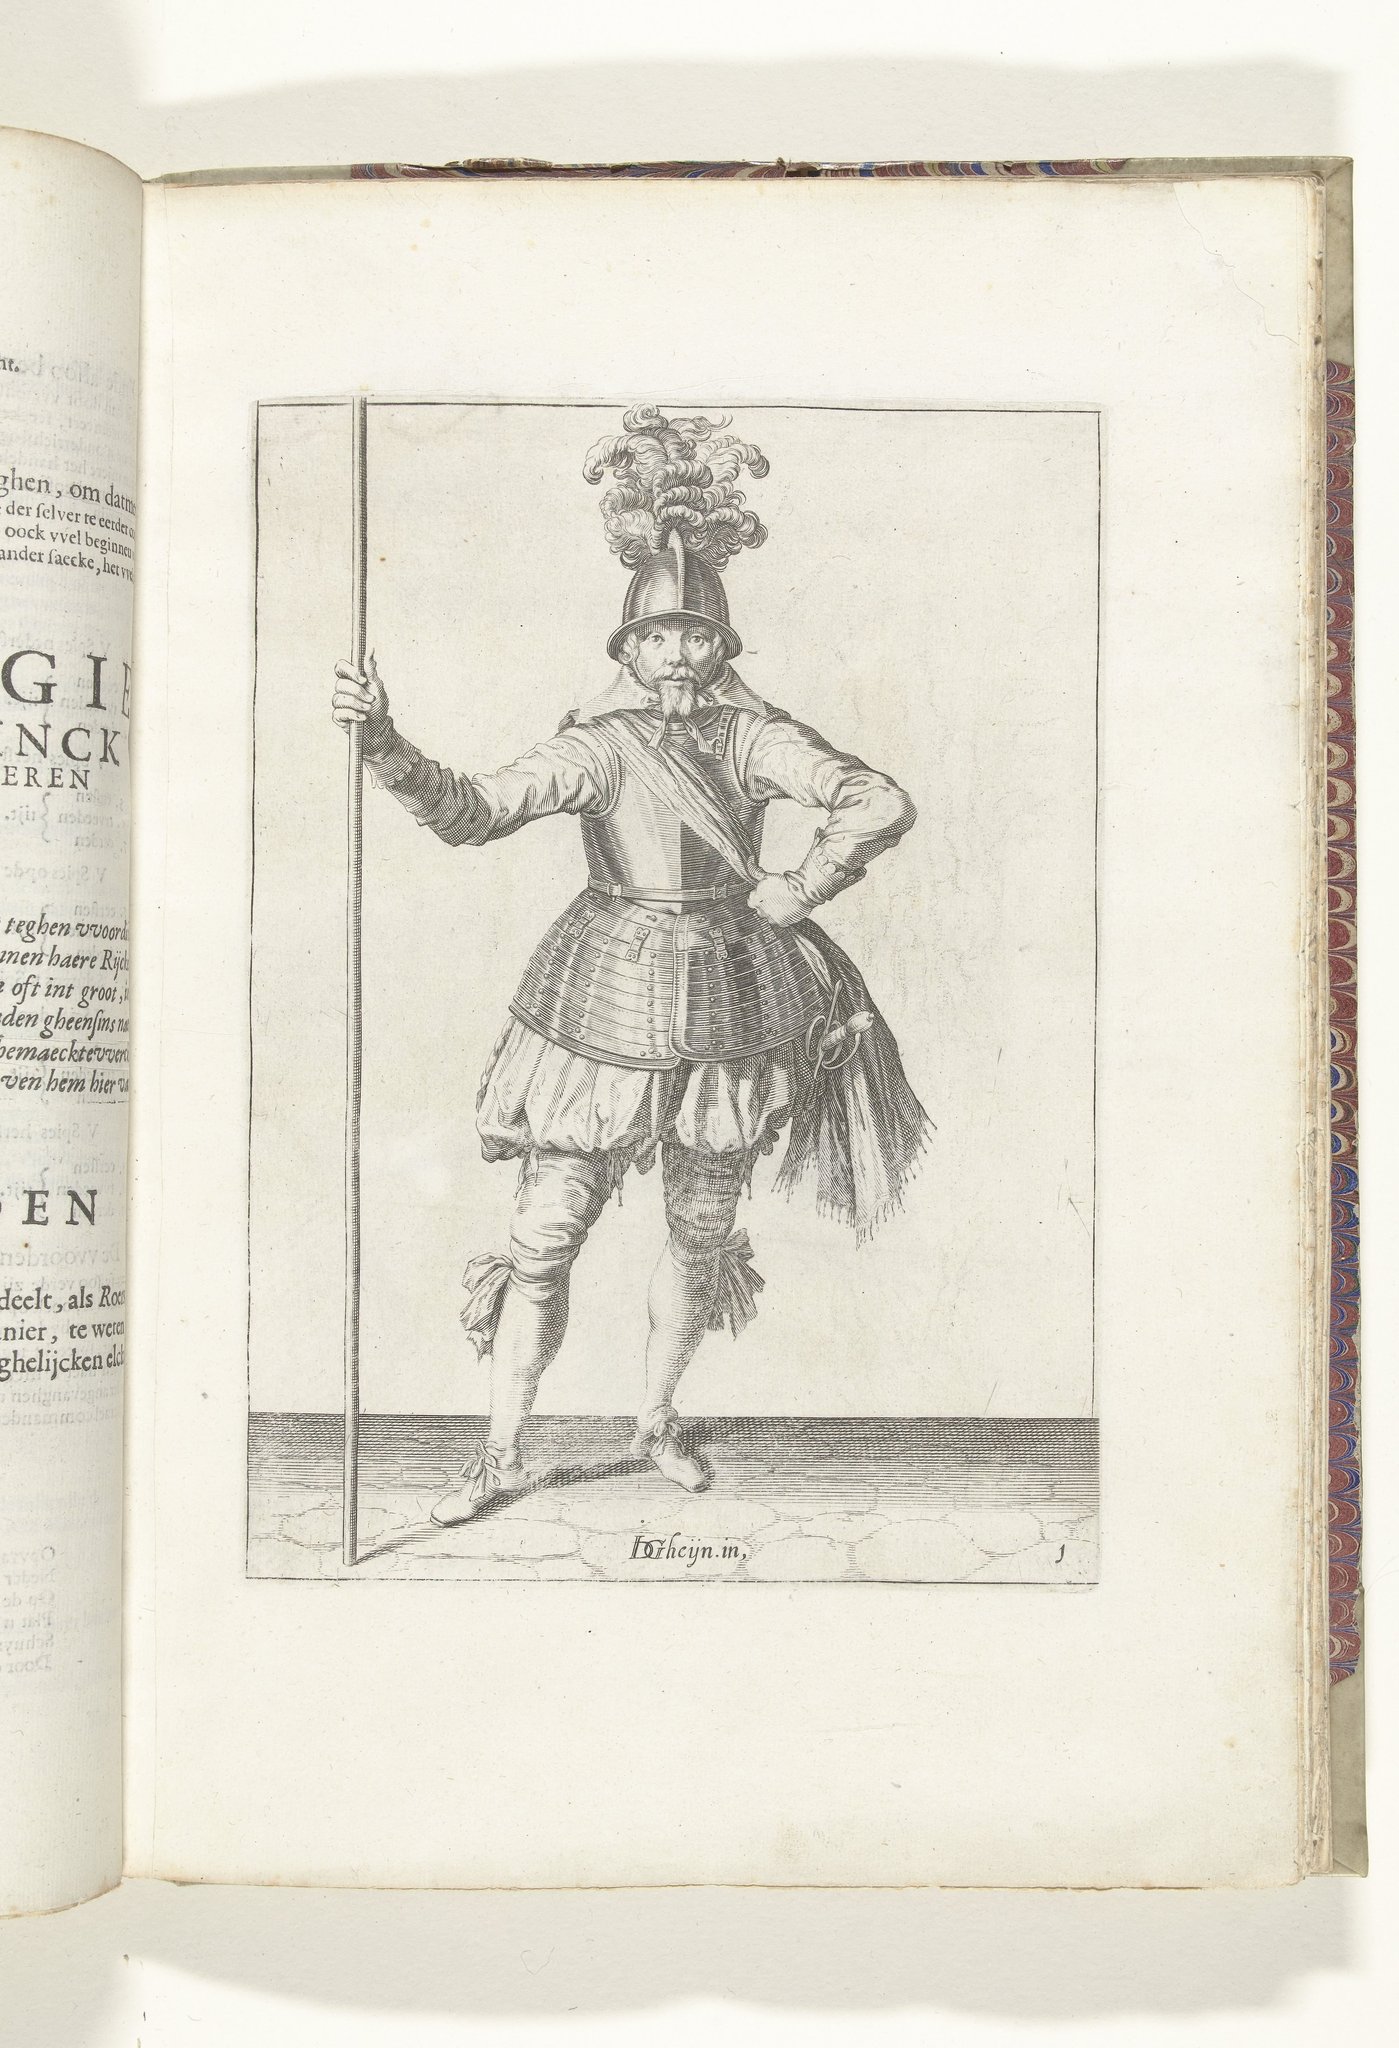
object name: print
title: Soldaat, van voren gezien, die zijn spies met zijn rechterhand rechtop vasthoudt (nr. 1), ca. 1600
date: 1597-1607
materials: paper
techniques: engraving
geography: amsterdam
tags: the hague, maurice (prince of orange), handling of weapons ~ military training, weapons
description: Illustratie in: J. de Gheyn, Wapenhandelinghe van roers, musquetten ende spiessen achtervolgende de ordre van ... Maurits Prince van Orangie ..., R. de Baudous, Amsterdam 1608. Het derde deel (met afgesneden platen): Corte onderwysinghe op de figuerliicke afbeeldinghe belanghende trechte gebruck, van alle t'ghene een Soldaet int handelen vande Spies noodich is, plaat 1. Dit exemplaar bevat alleen de tekstbladen voor het tweede en derde deel. In het exemplaar in de collectie van de Rijksmuseum Research Library (326 F 16).